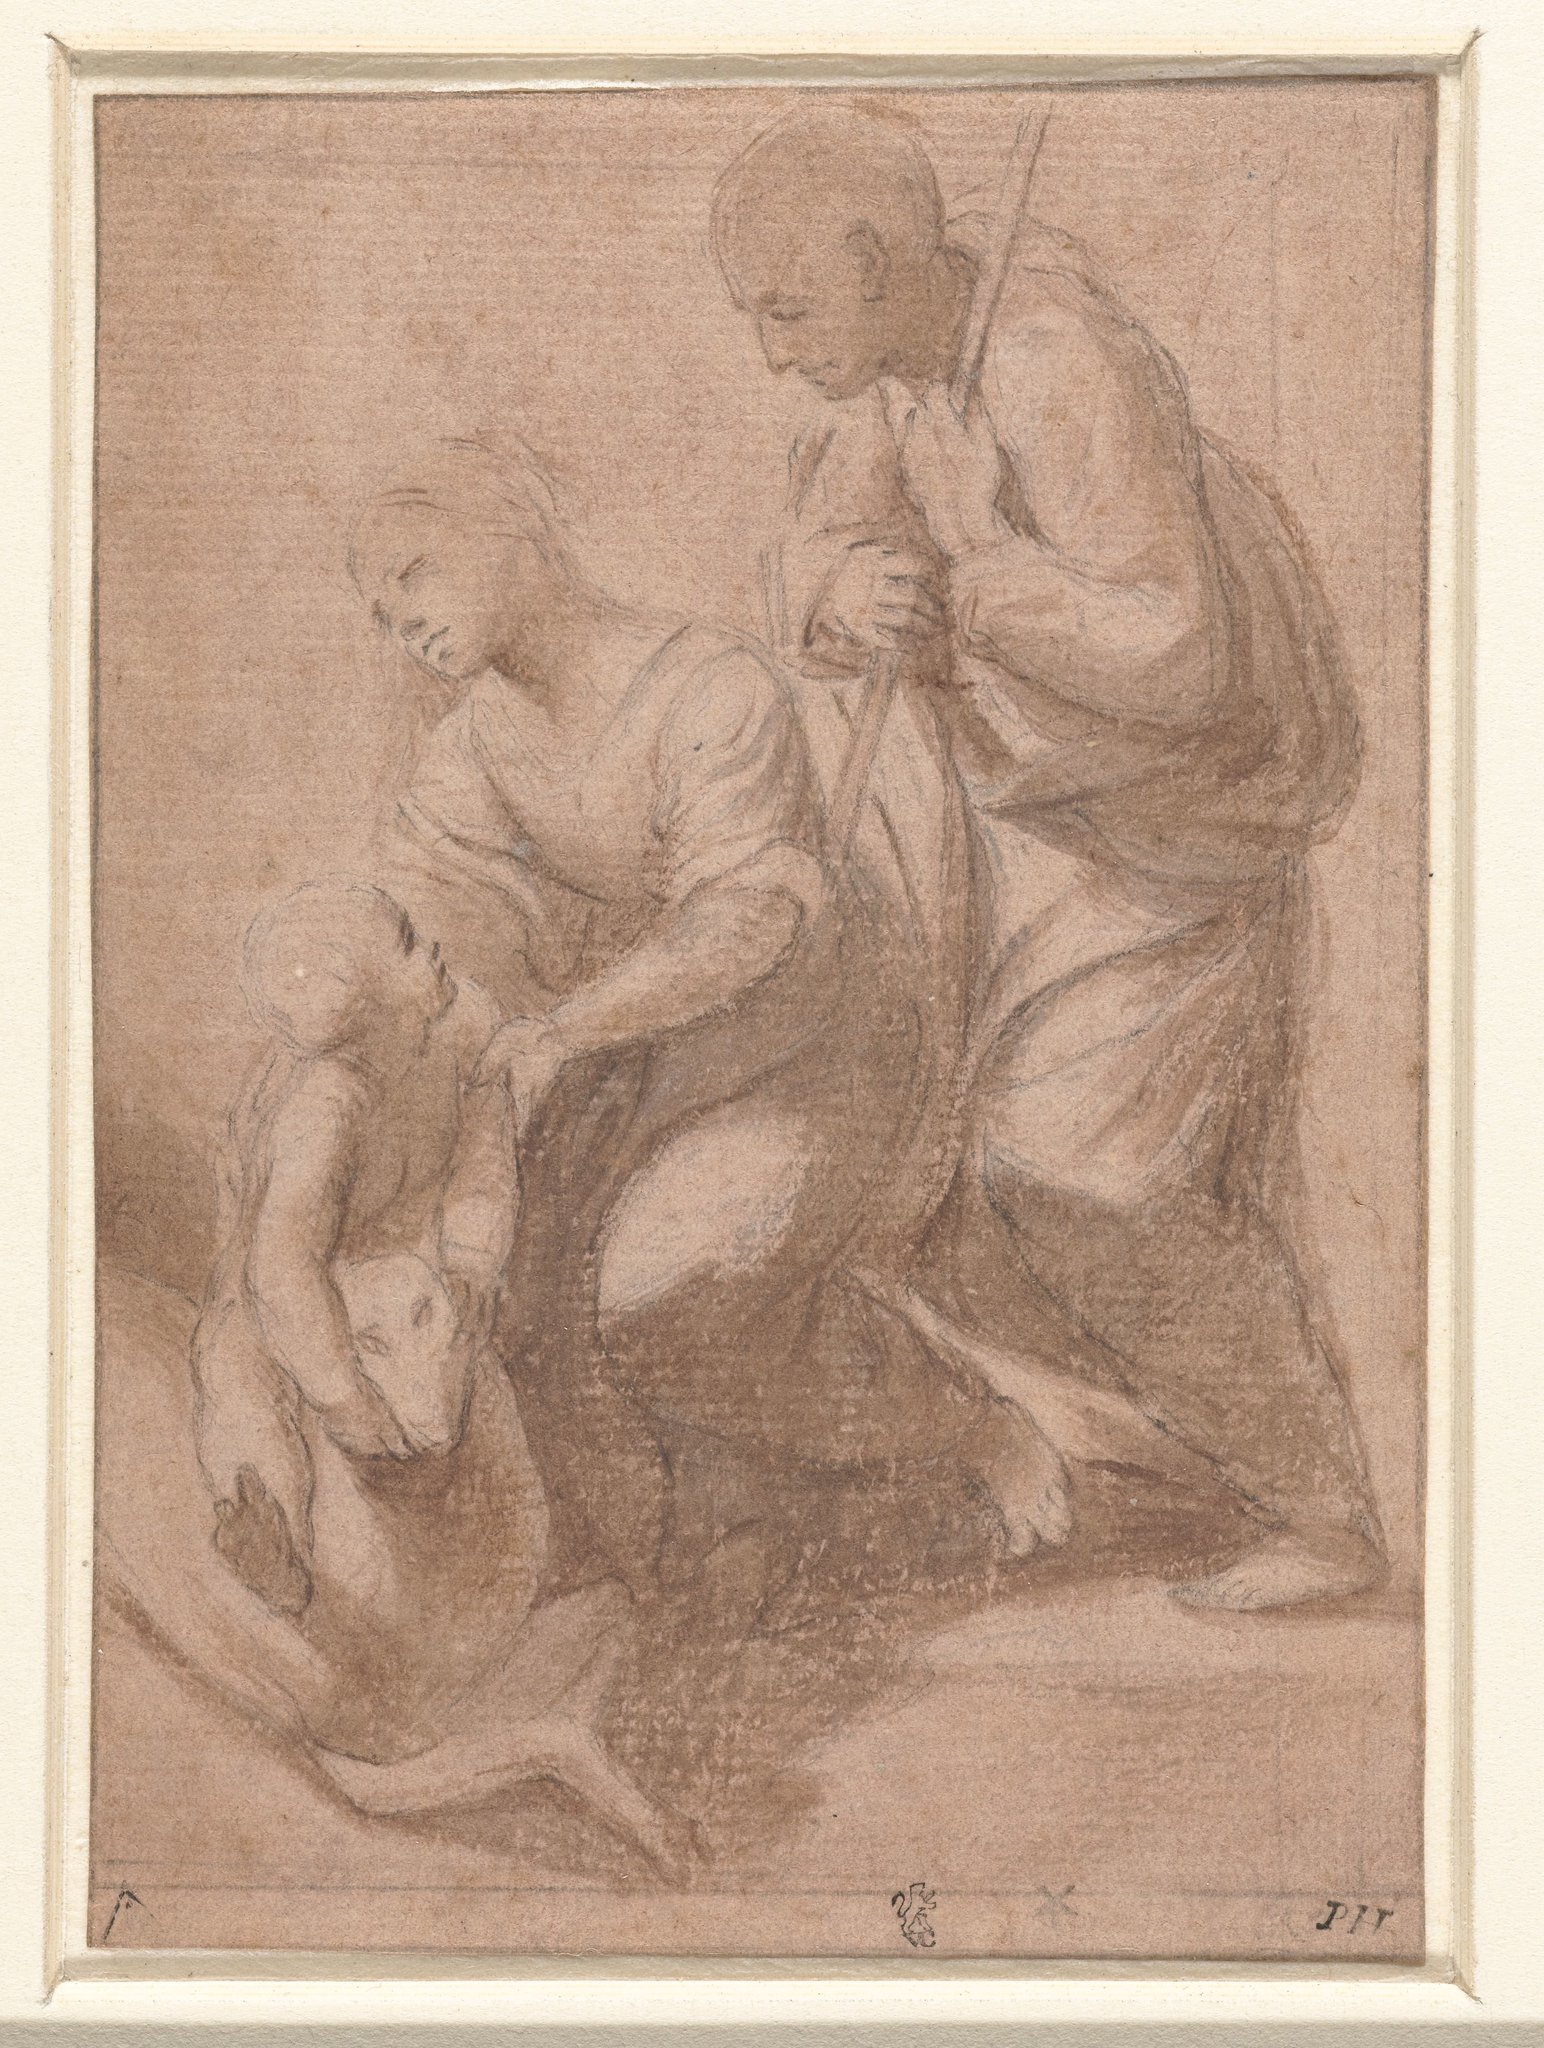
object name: drawing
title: Heilige Familie met een lam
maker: Anonymous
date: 1500-1620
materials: chalk, paper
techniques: brush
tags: holy family, and derived representations